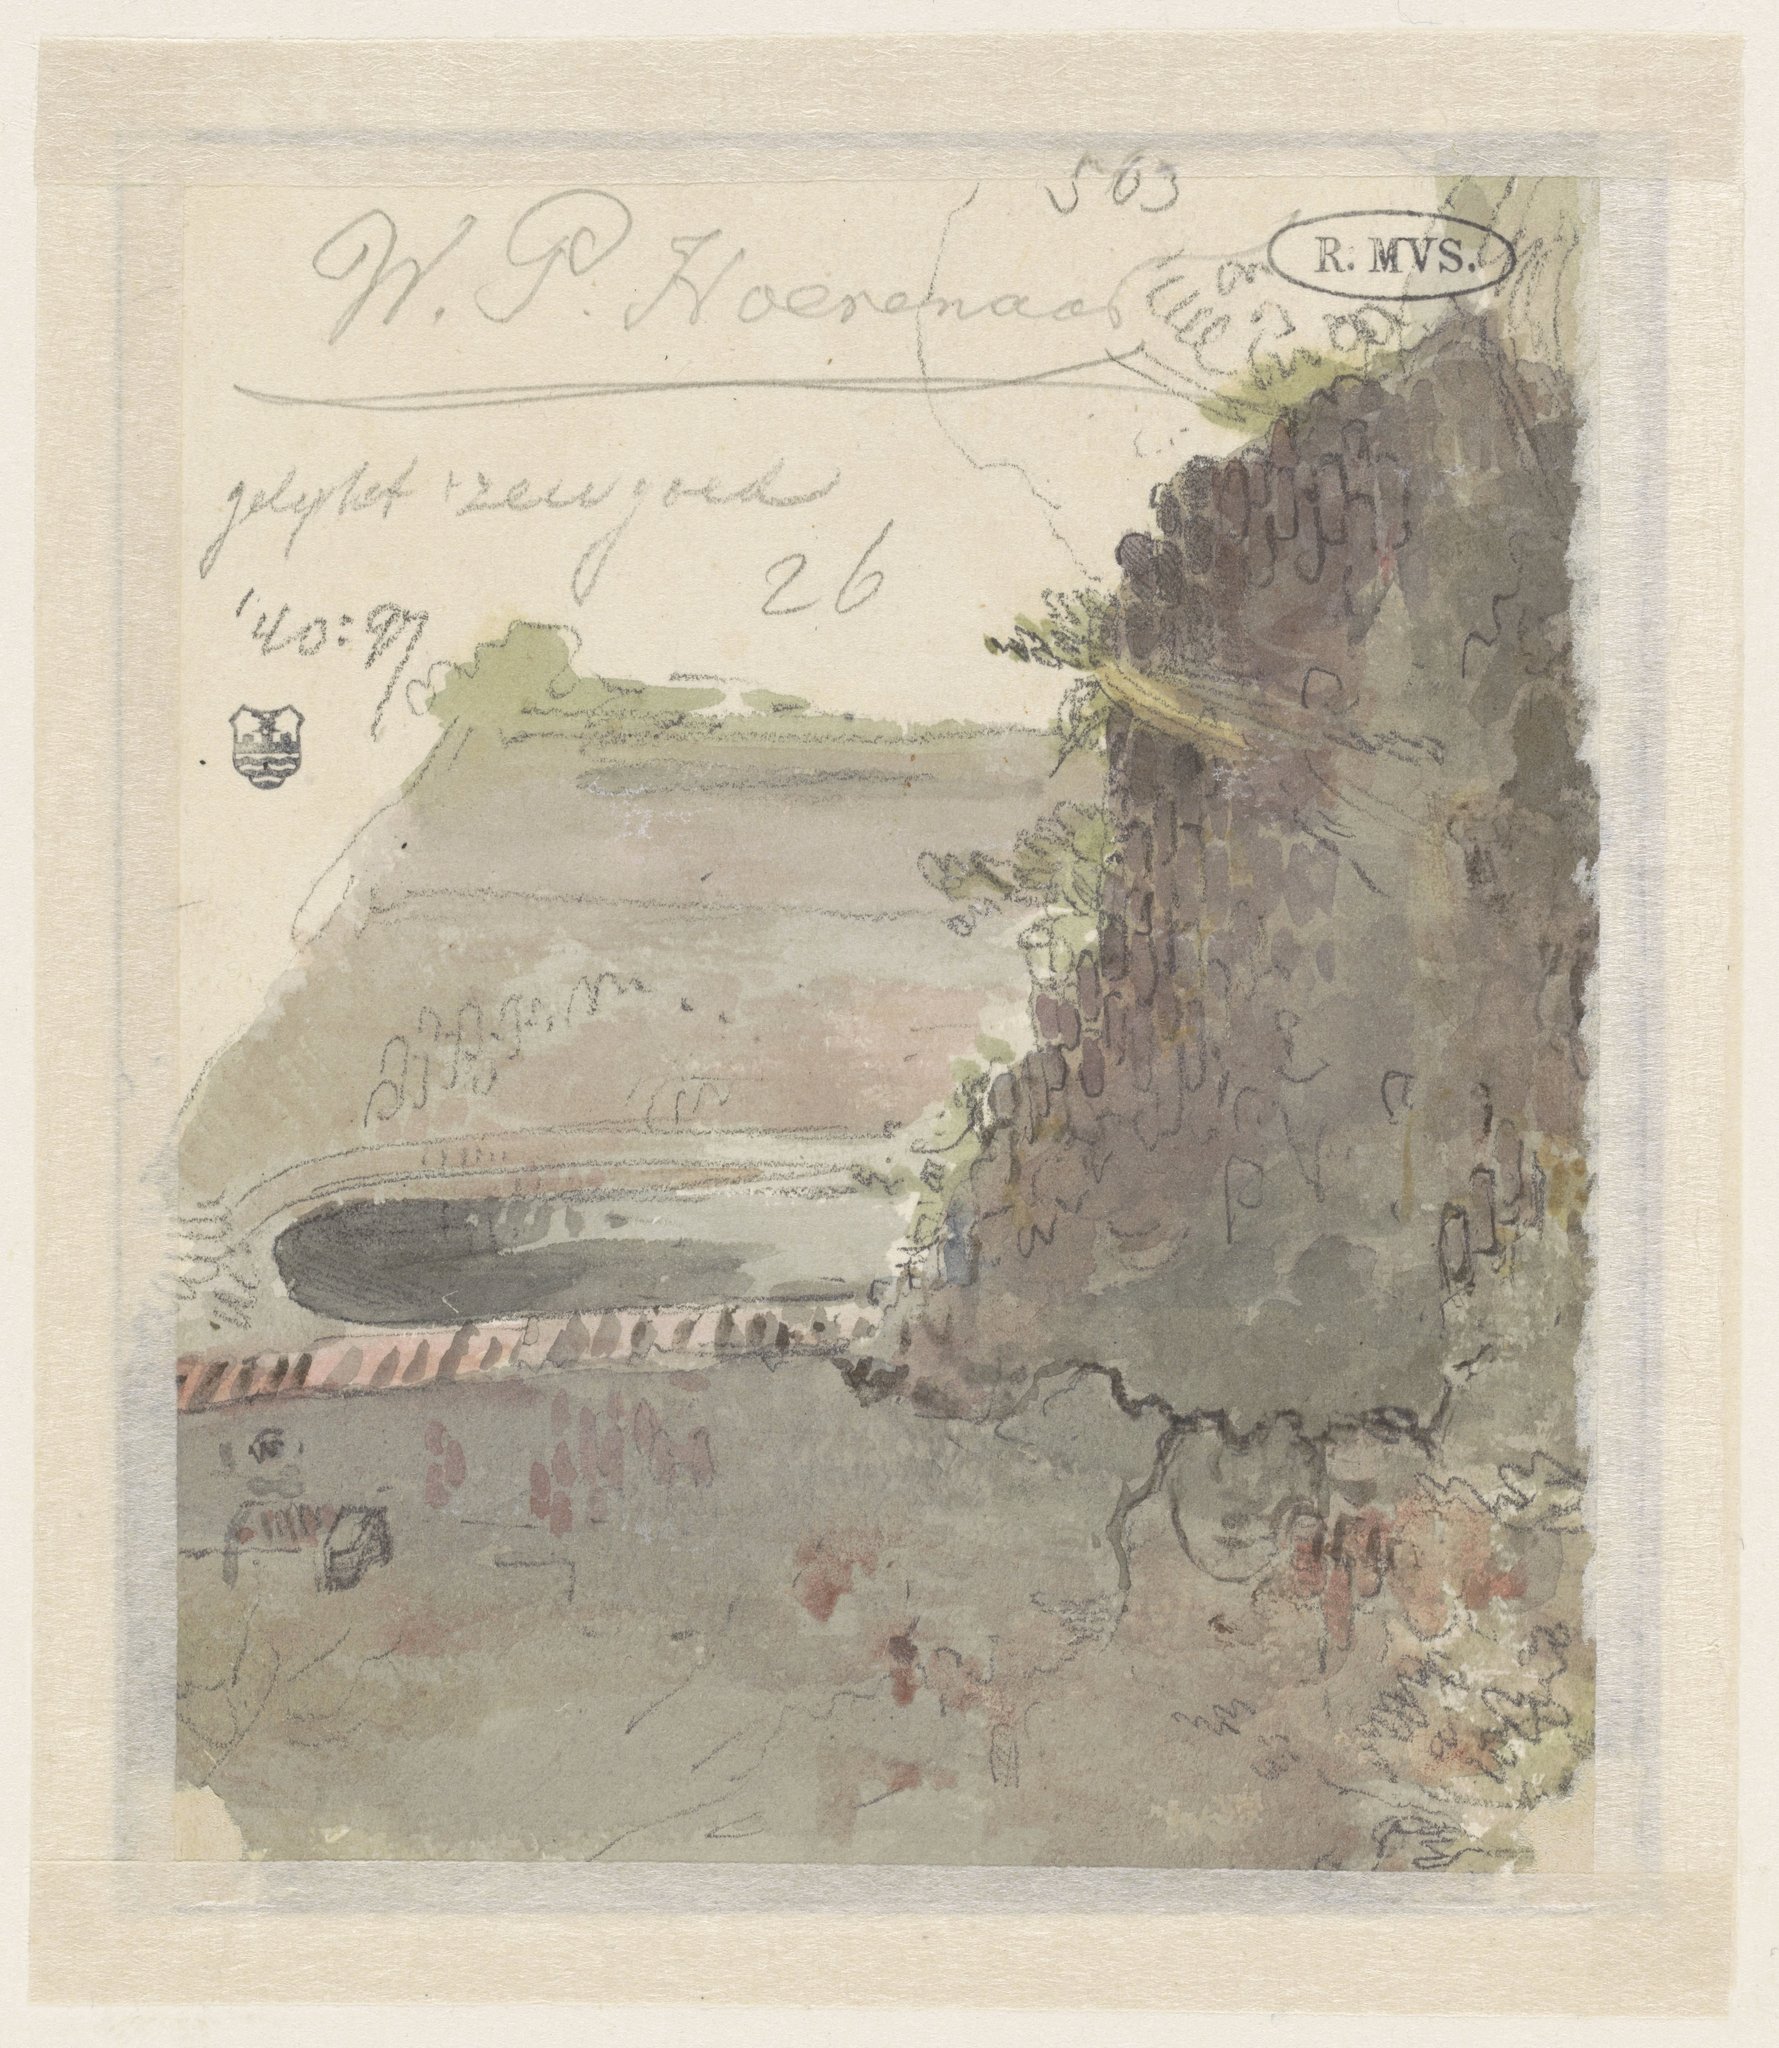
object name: drawing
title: Ruïne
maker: gijsbertus craeyvanger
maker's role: draughtsman, print maker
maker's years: 1810-1895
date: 1828-1863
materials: paper, pencil, watercolor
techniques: brush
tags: ruin of a building ~ architecture